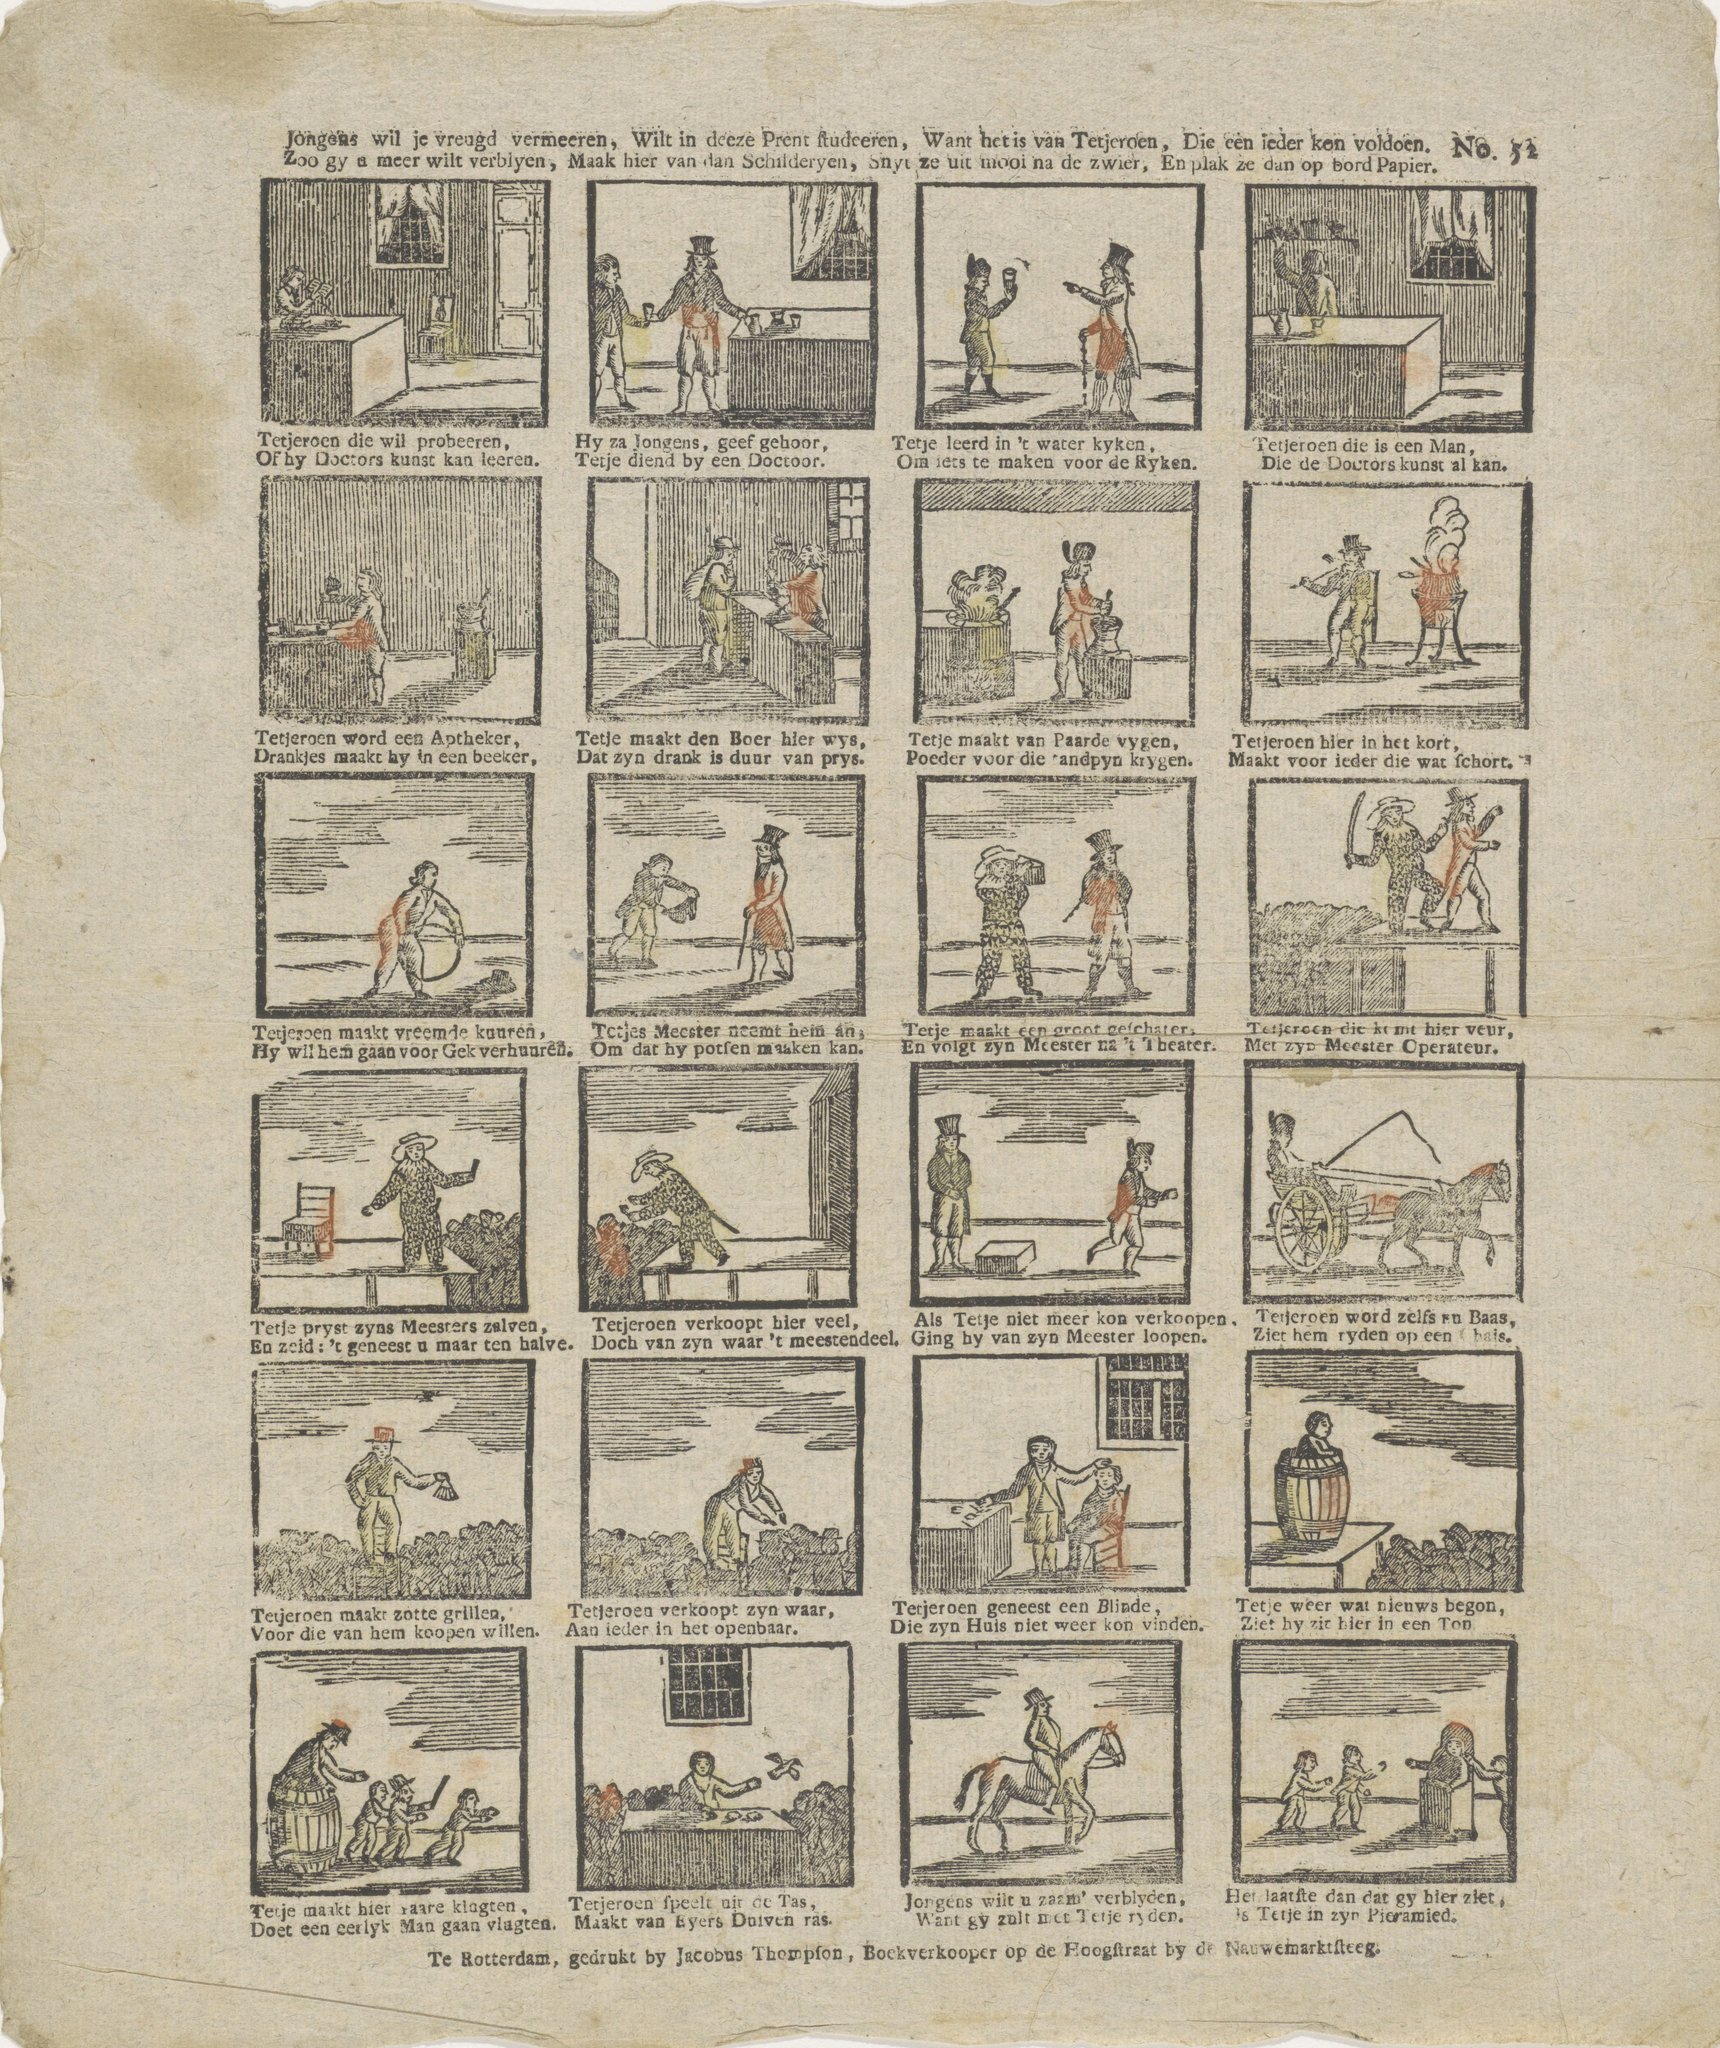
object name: print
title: Jongens wil je vreugd vermeeren, Wilt in deeze prent studeeren, Want het is van tetjeroen, Die een ieder kon voldoen. / Zoo gy u meer wilt verblyen, Maak hier van dan schilderyen, Snyt ze uit mooi na de zwier, En plak ze dan op bord papier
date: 1791-1812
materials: paper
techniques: colour, letterpress printing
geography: rotterdam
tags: quack, charlatan, mountebank, 'saltimbanco', tales and fairy tales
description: Blad met 24 voorstellingen over de vele vaardigheden en kunsten van Tetjeroen. Onder elke afbeelding een tweeregelig vers. Genummerd rechtsboven: No. 52.